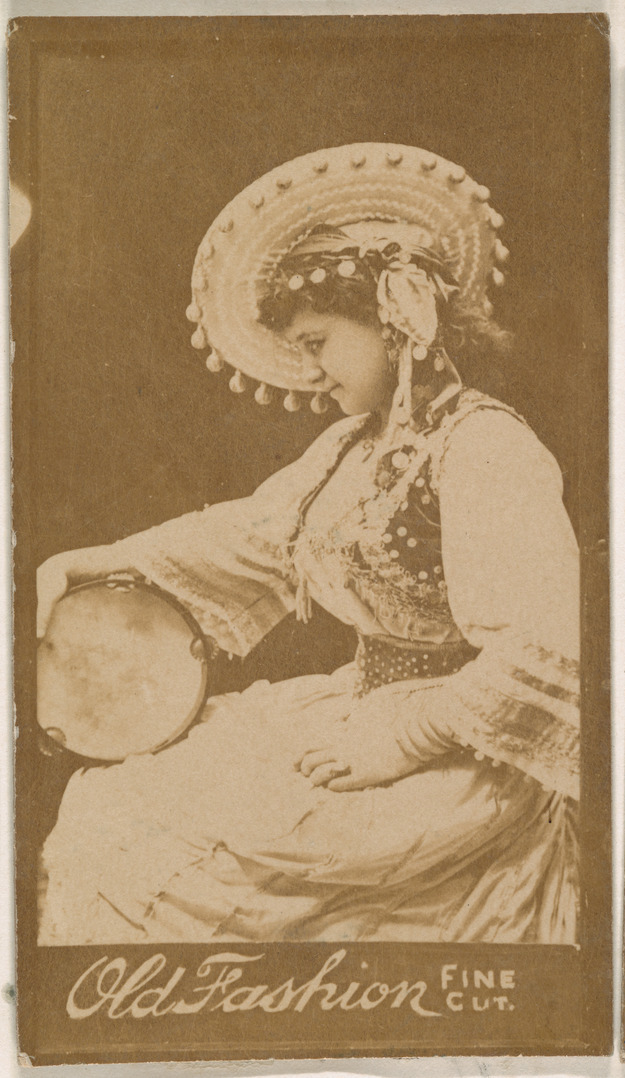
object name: photograph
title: Actress posing with tambourine, from the Actresses series (N664) promoting Old Fashion Fine Cut Tobacco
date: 1888-1890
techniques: albumen silver print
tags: portraits,women,actresses